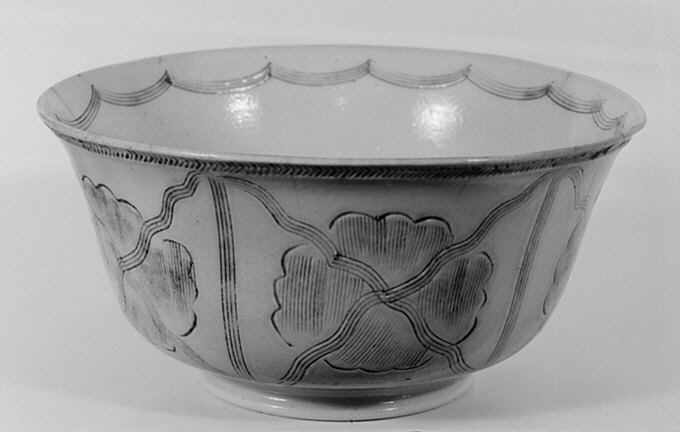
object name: bowl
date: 1750-1770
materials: stoneware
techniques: salt glaze